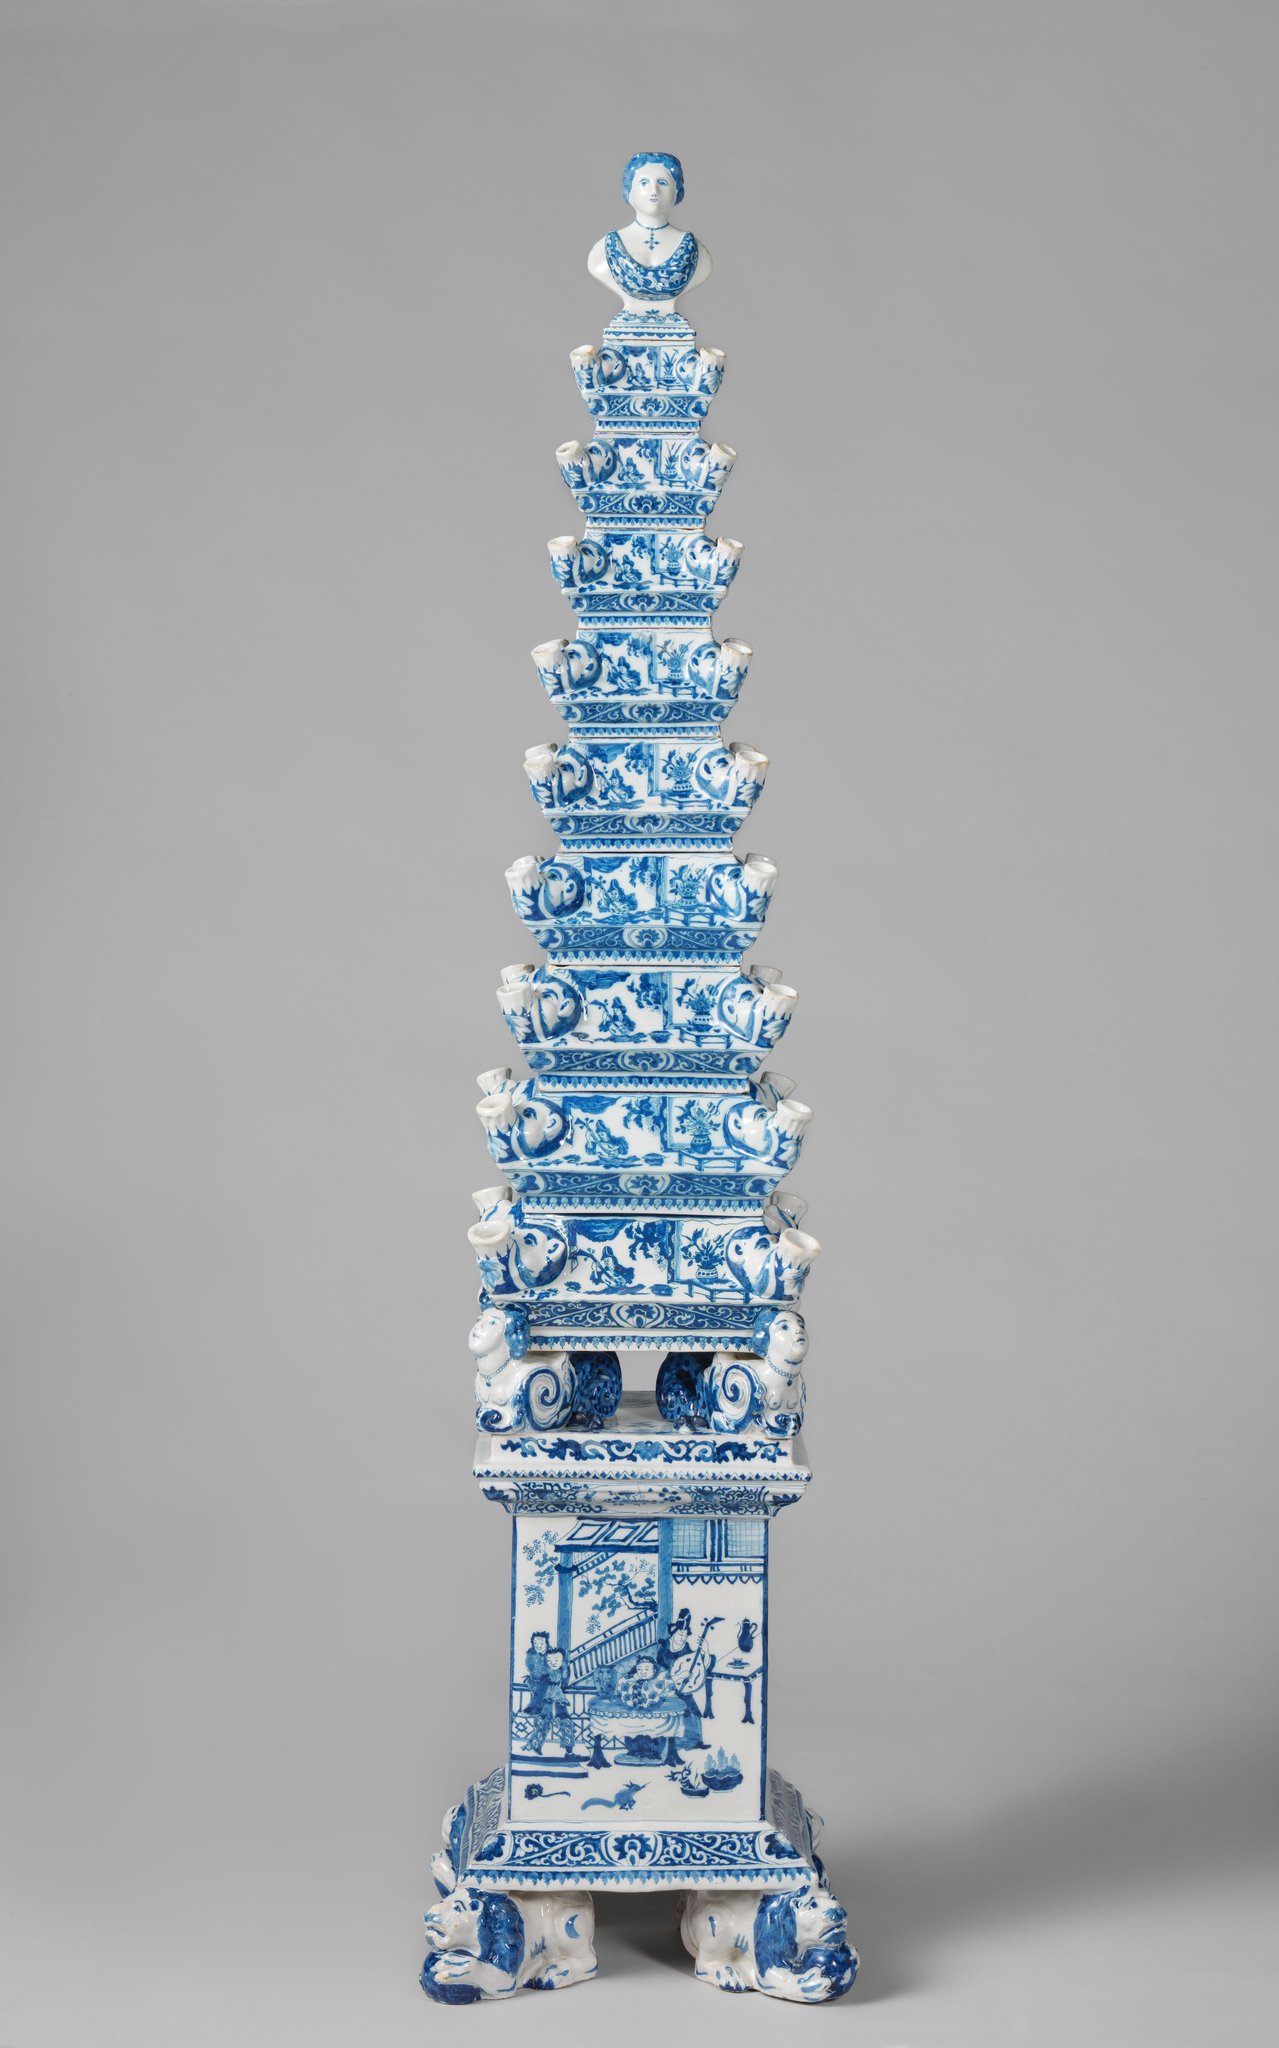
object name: bloempiramide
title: Flower pyramid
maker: lambertus van eenhoorn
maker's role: plateelbakker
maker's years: 1651-1721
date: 1692-1700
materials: earthenware, glaze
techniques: painted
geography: delft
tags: flowers, one person playing string instrument (plucked), beasts of prey, predatory animals: lion, chest, bust - aa - female human figure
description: Segment van bloempiramide van faience, blauw beschilderd in de glazuur. Musicerende figuren en figuren met schaal.